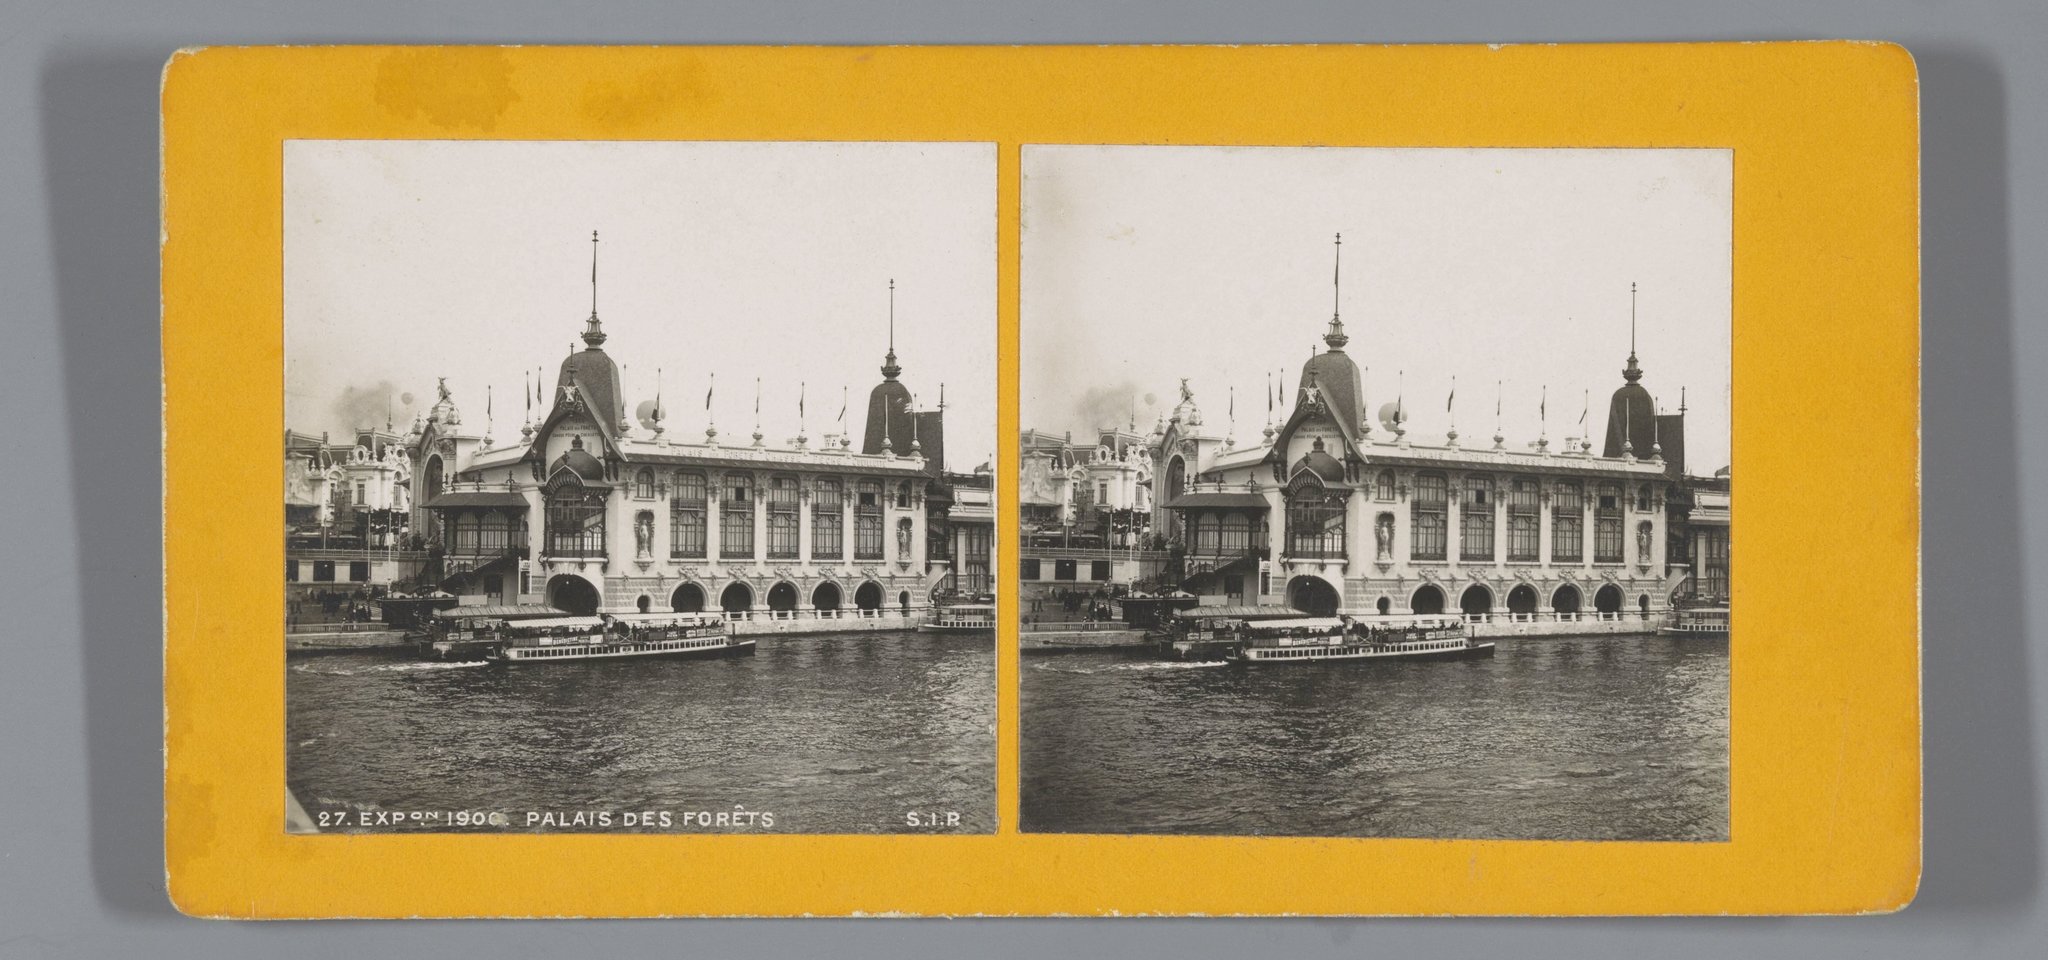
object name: stereograph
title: Expon 1900. Palais des Forêts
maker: Anonymous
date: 1900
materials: paper, cardboard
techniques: gelatin silver print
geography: paris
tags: river, world fair, world exhibition, exterior ~ representation of a building, paris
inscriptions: number: ‘27.’